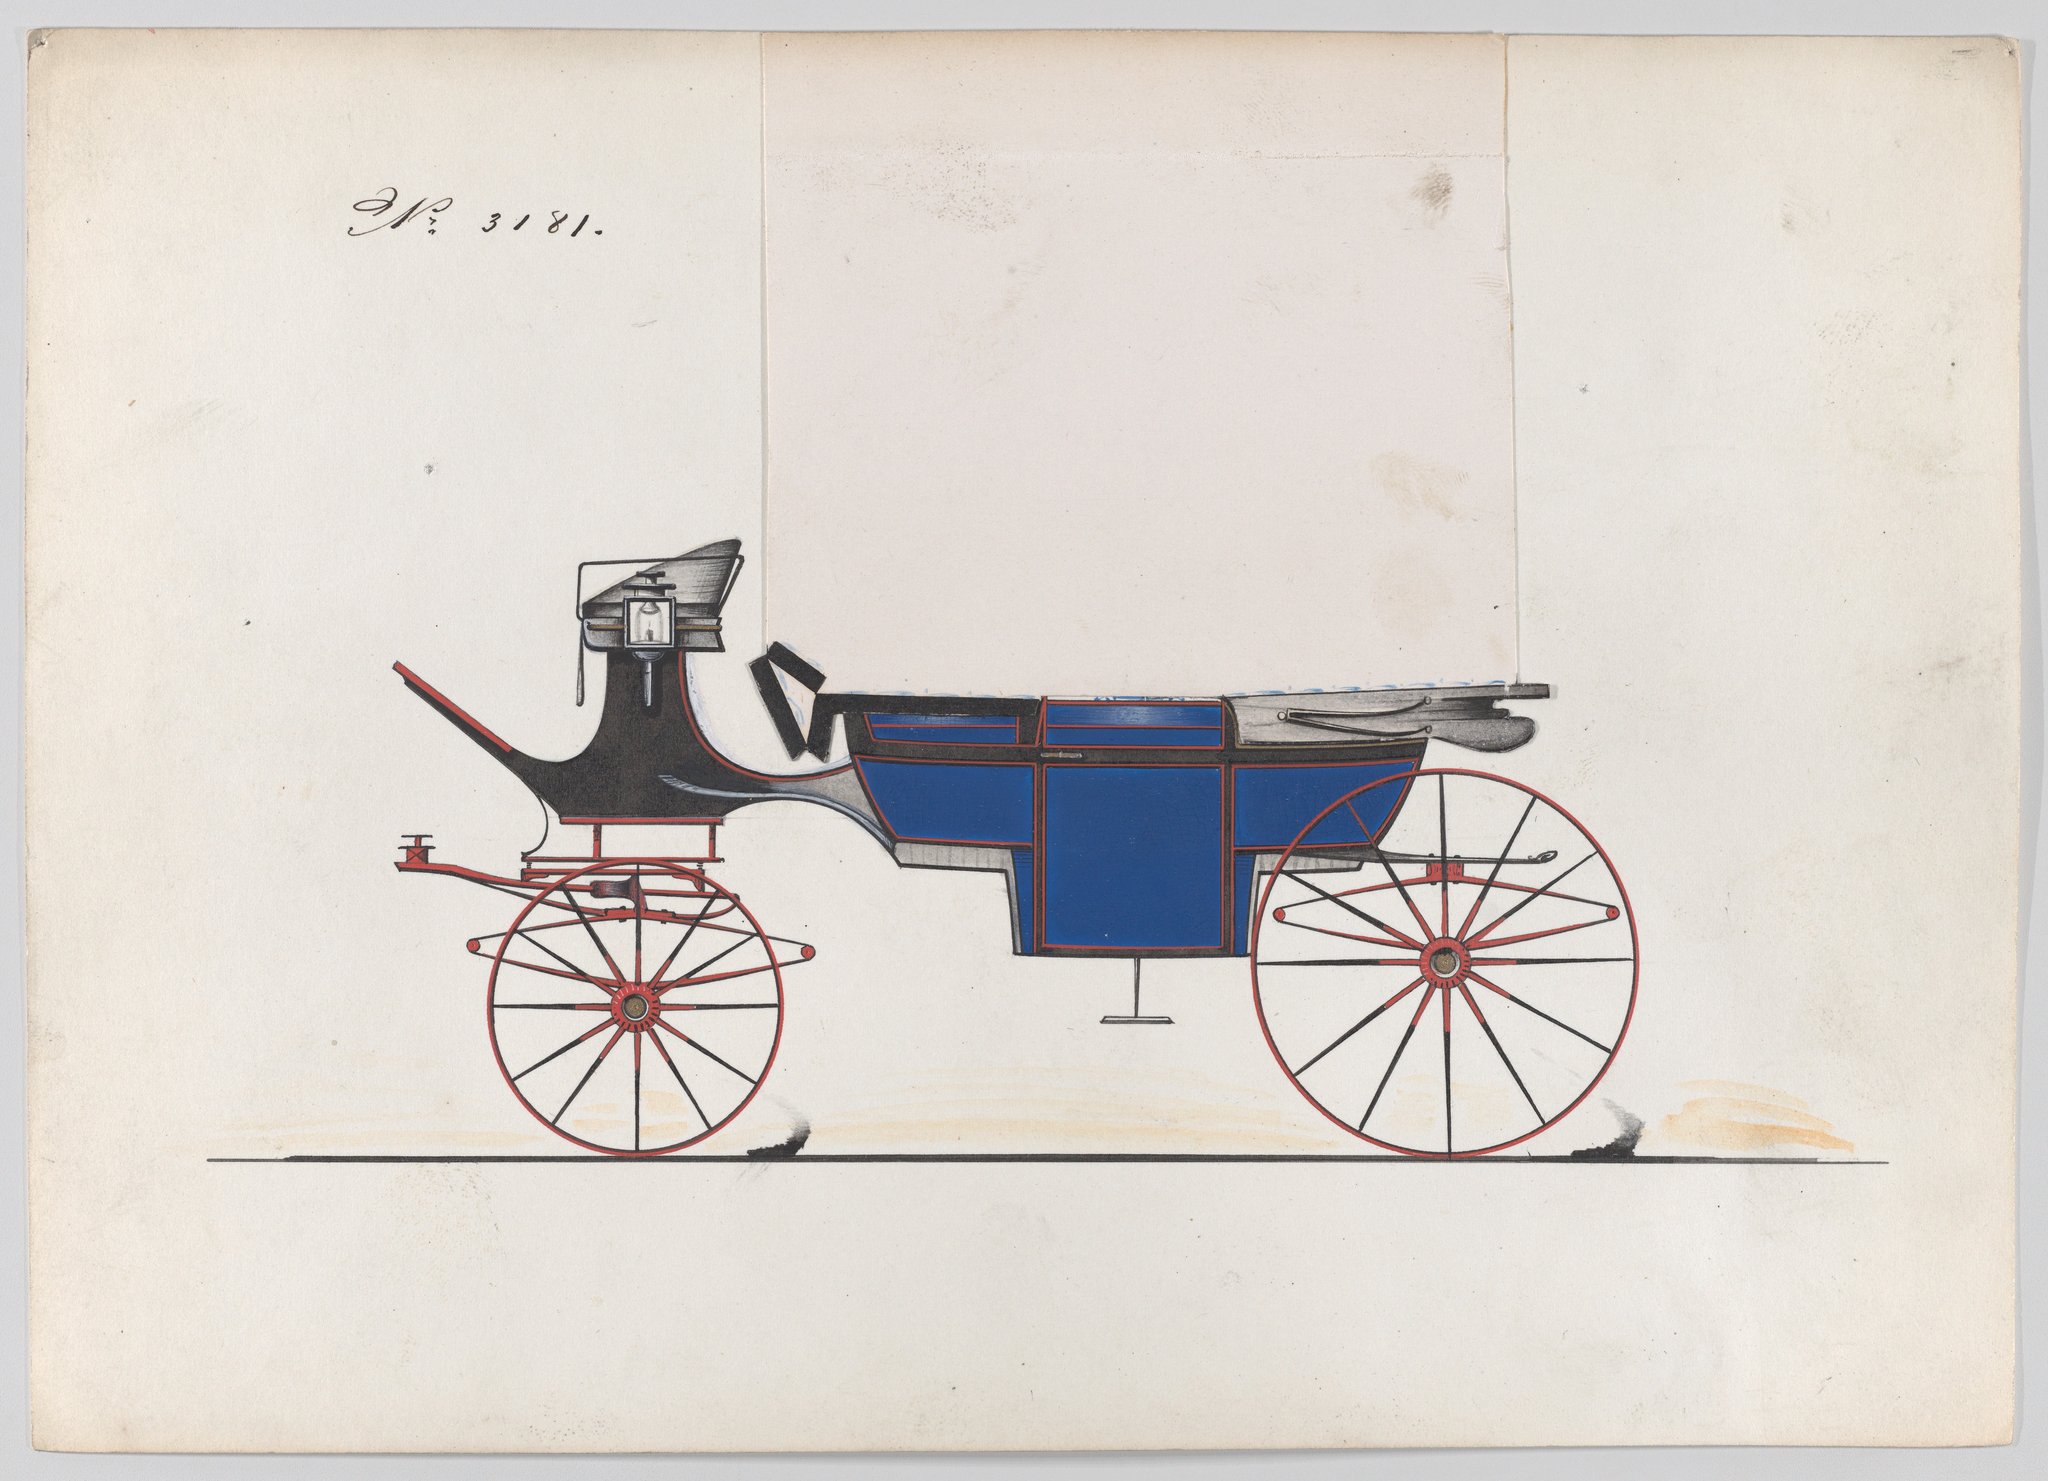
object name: drawing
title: Design for Landau, No. 3181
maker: brewster & co.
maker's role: manufacturer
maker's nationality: american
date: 1876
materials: gouache, ink, watercolor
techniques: pen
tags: carriages